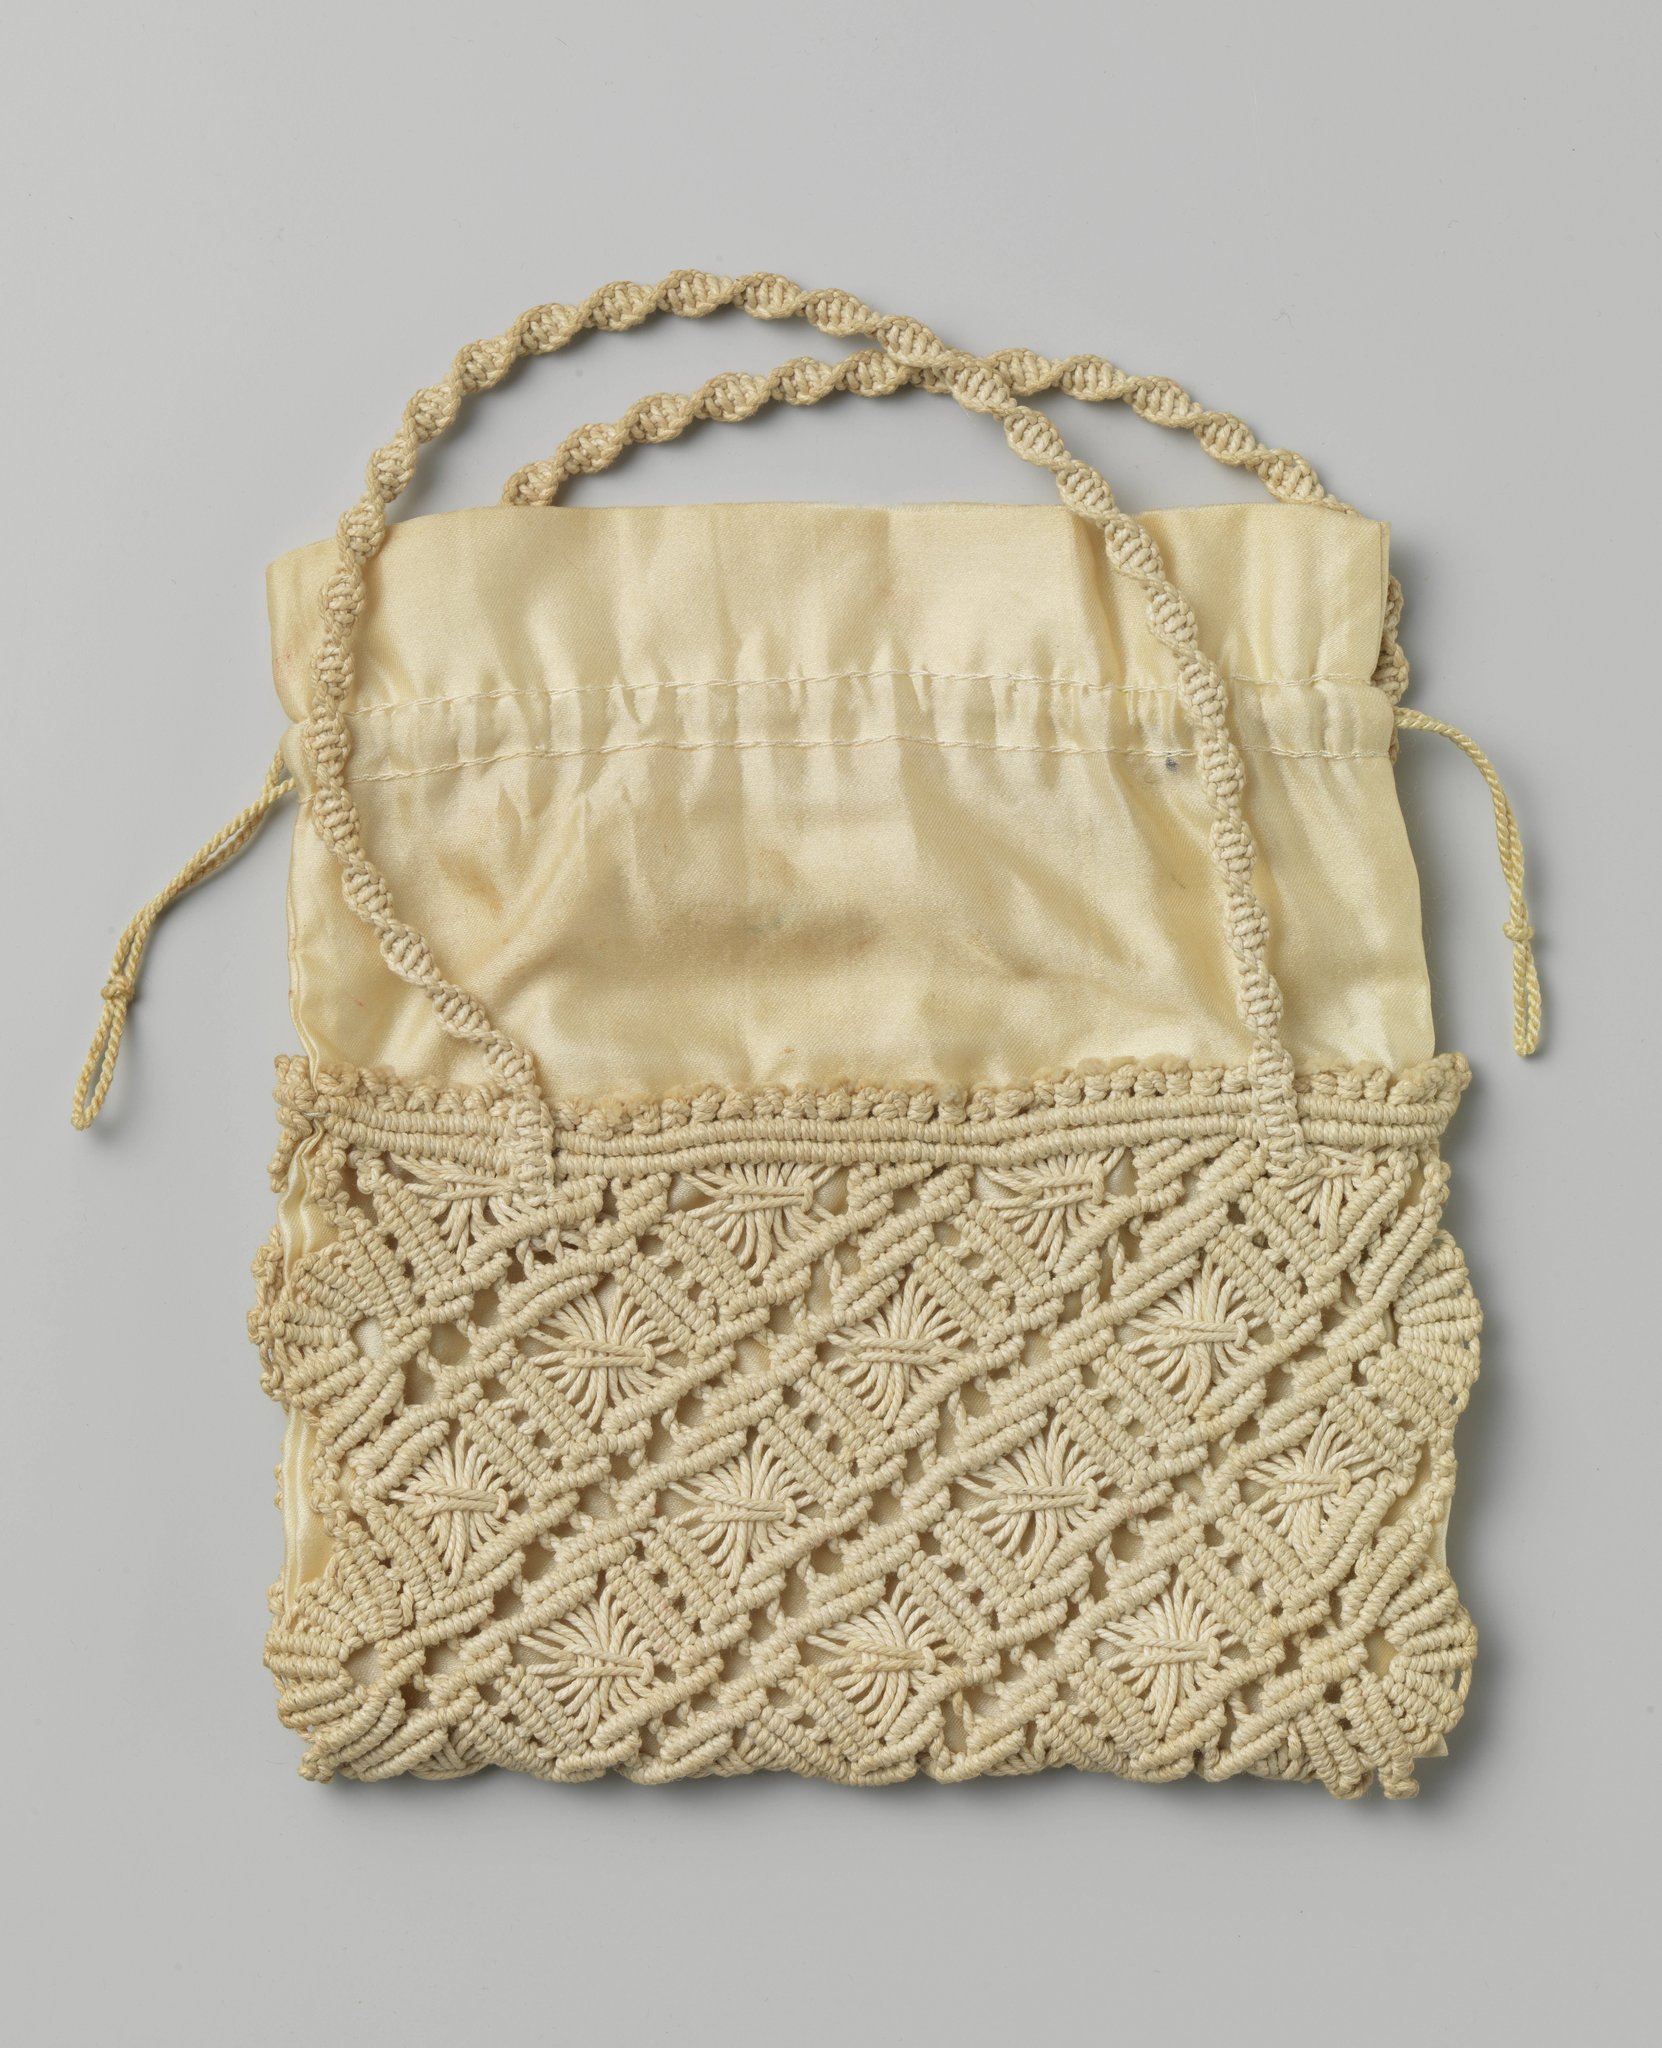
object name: bag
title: Tas in een plat, rechthoekig model, van crèmekleurig katoen macramé met een crèmekleurige satijnen voering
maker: Anonymous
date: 1920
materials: cotton, silk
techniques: macrame, weave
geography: netherlands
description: Tas in een plat, rechthoekig model, waarvan de onderste helft van crèmekleurig katoen macramé is, dat in een patroon van diagonale banen is geknoopt. Aan beide kanten een hengsel van macramé, dat zo geknoopt is dat het een helixvorm krijgt. De tas is gevoerd met een crèmekleurige satijn, die gedeeltelijk boven het geknoopte deel uitsteekt. In de zijde is een tunnel genaaid, waardoor een gedraaid crèmekleurig koord is geregen.